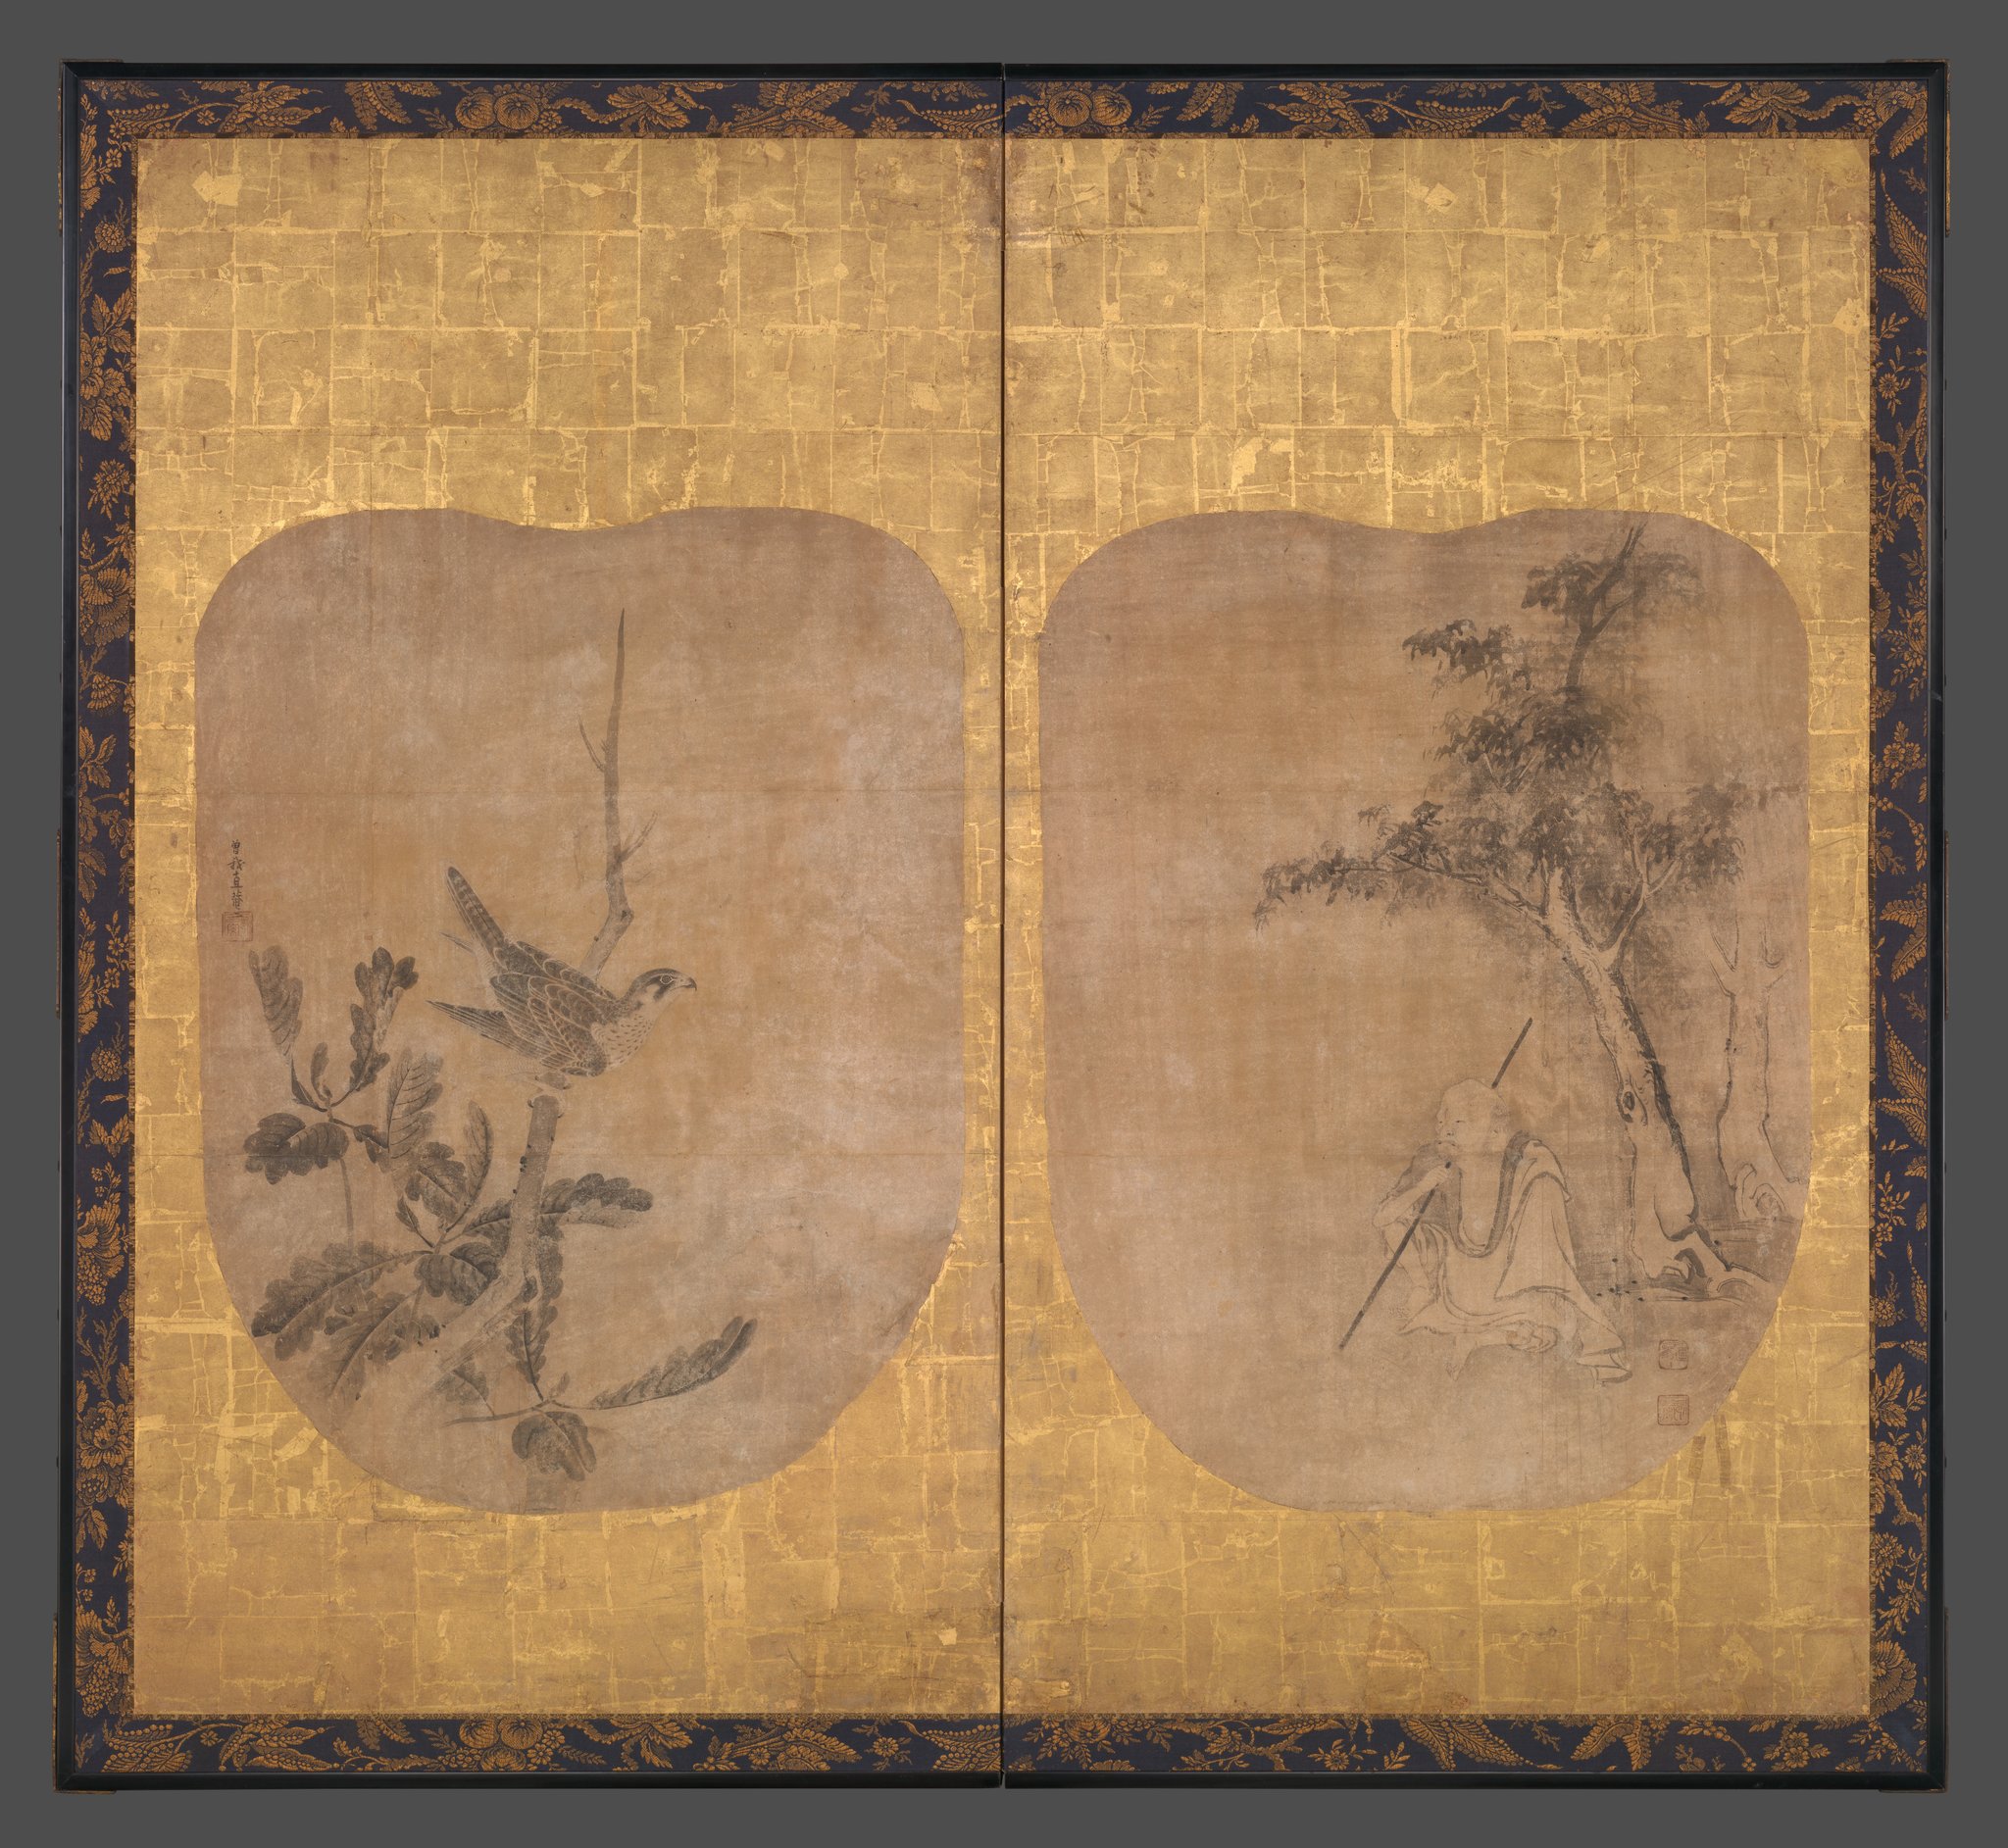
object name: screen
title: Daoist Sage and Hawk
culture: japanese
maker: soga nichokuan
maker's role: artist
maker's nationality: japanese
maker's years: 1600-1700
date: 1634-1666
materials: ink, panel, paper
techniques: painting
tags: hawks,men,trees